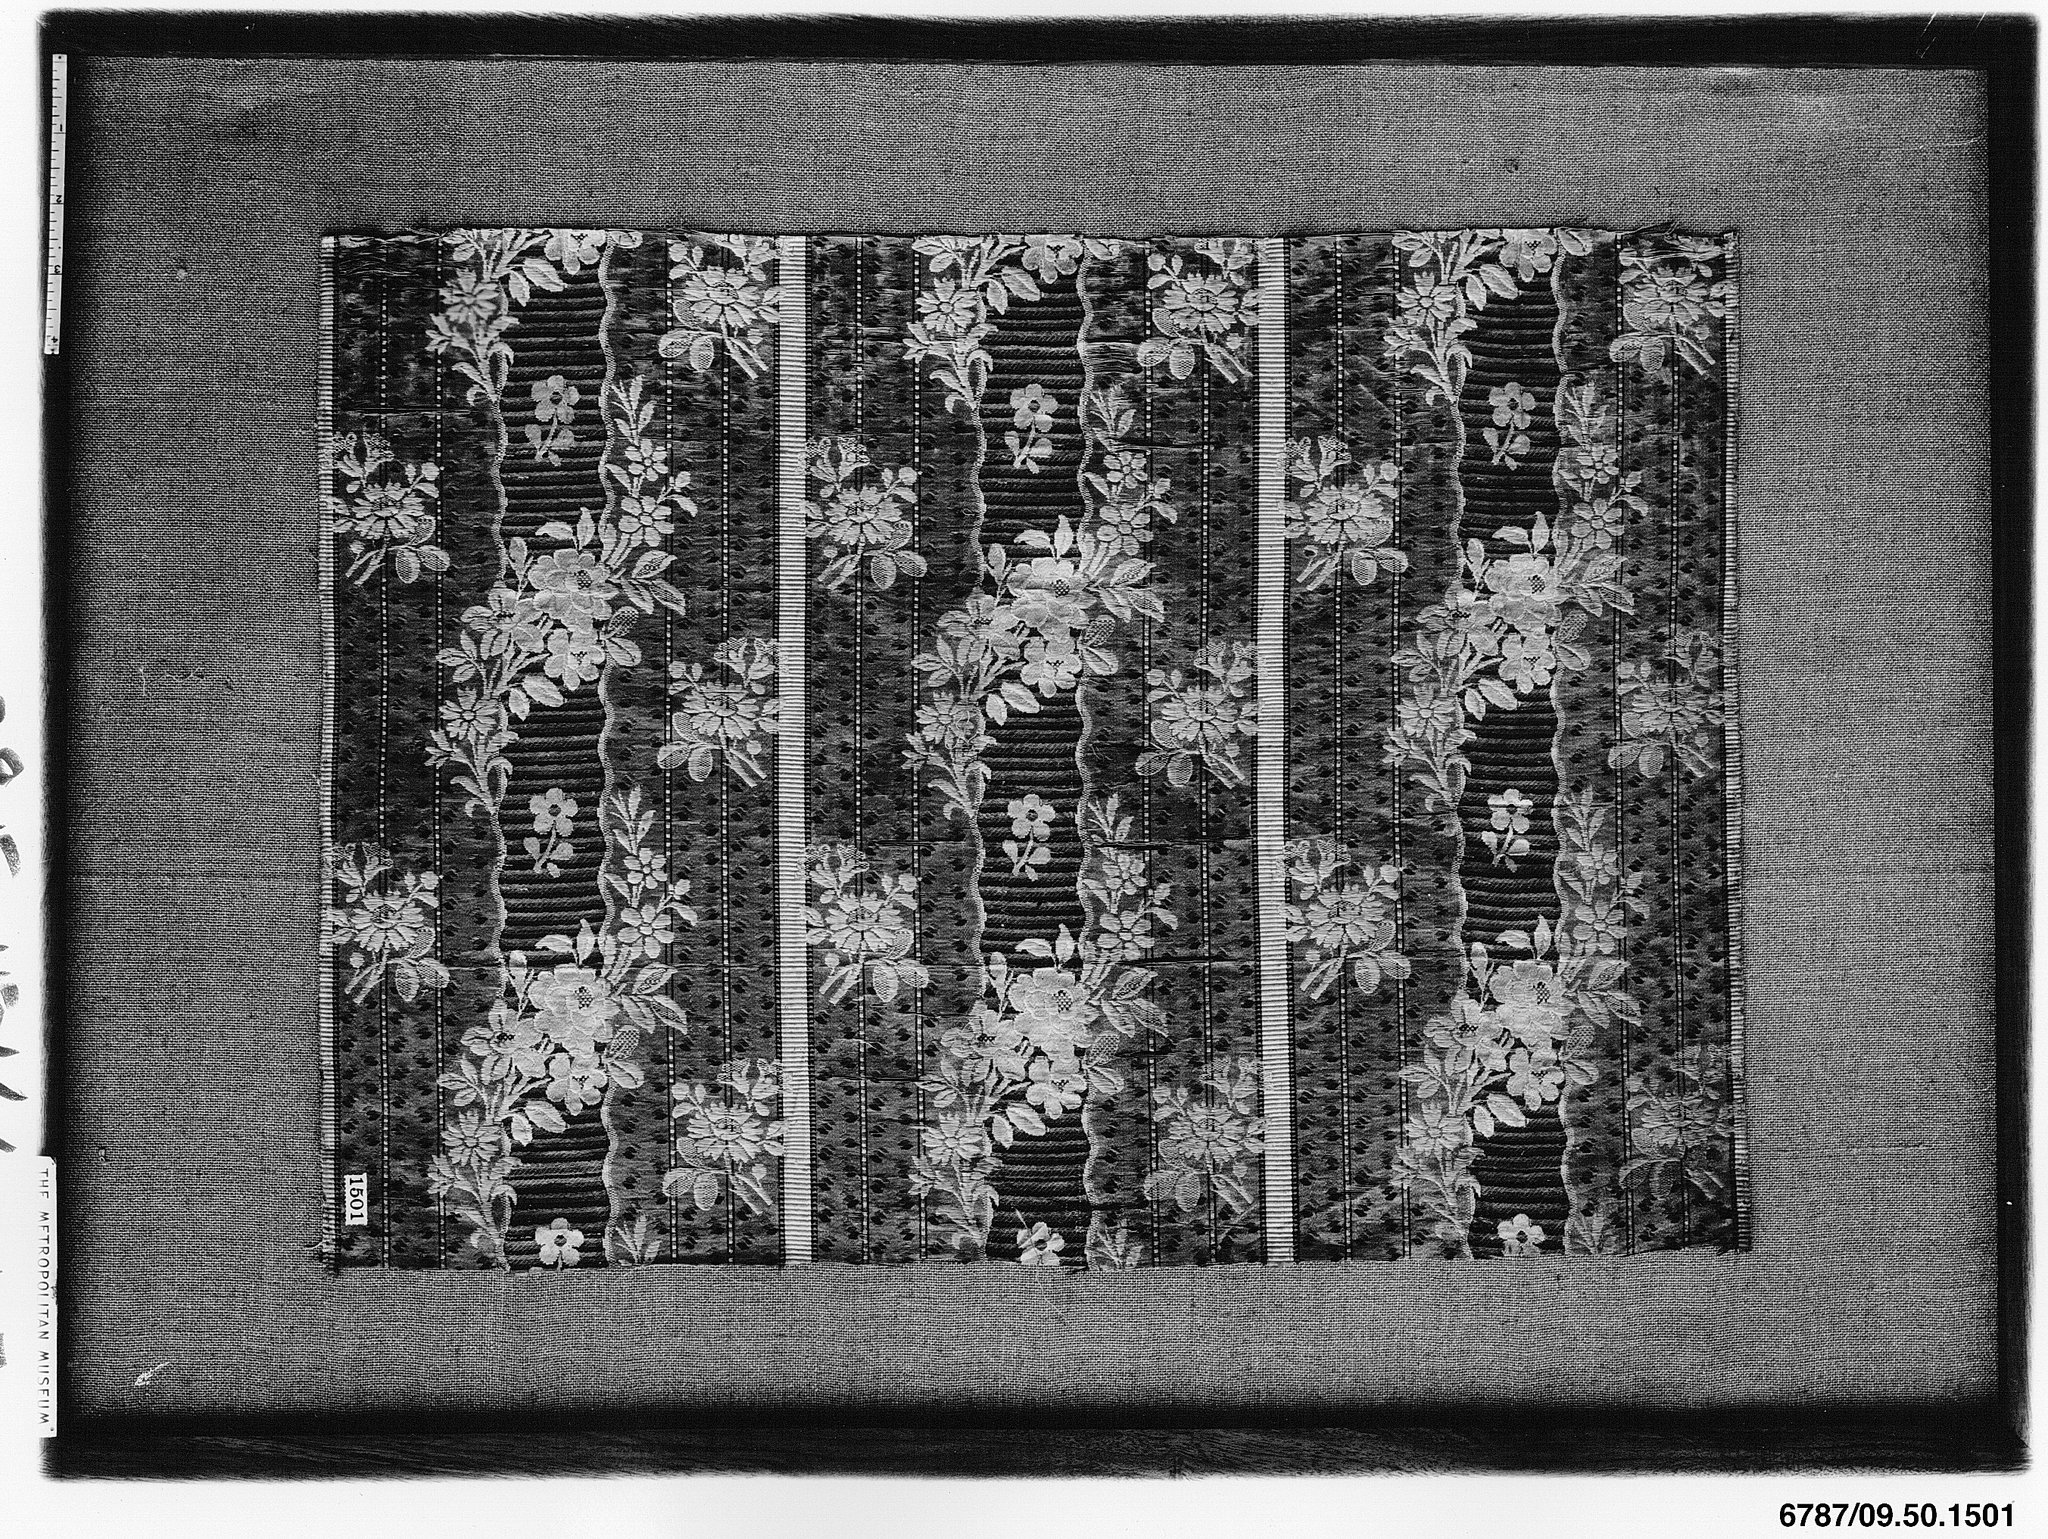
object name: piece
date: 1801-1900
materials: silk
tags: flowers,leaves